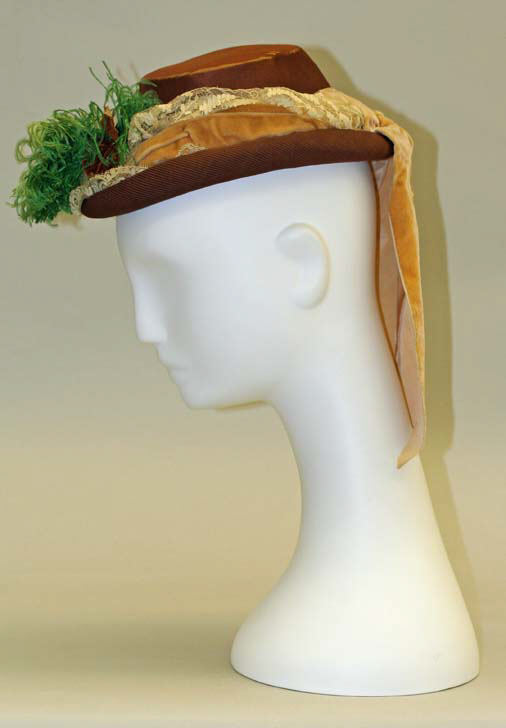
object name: hat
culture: american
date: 1870-1874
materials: silk